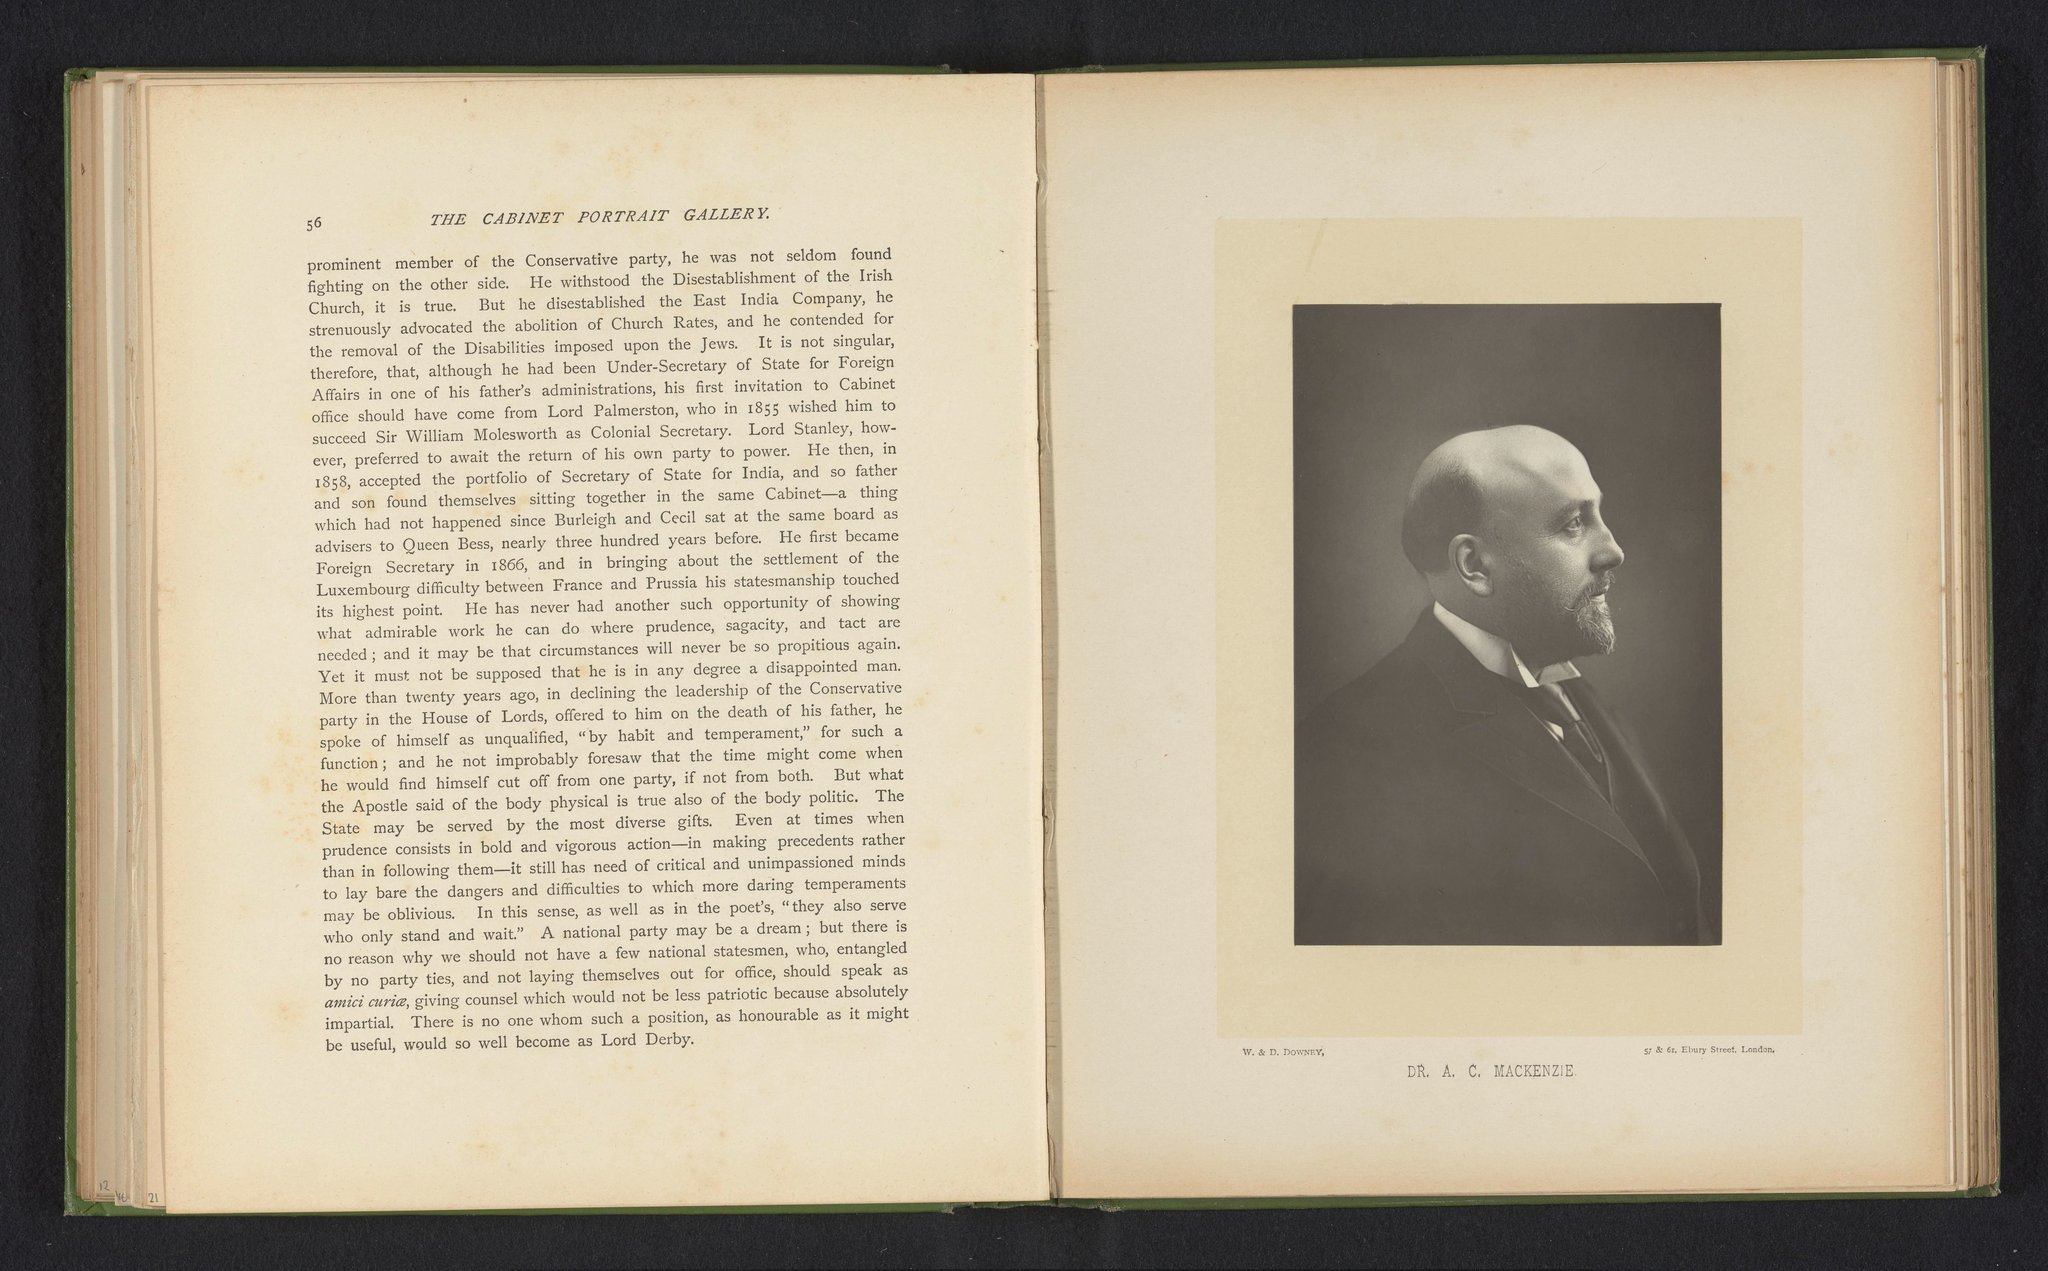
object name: photomechanical print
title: Portret van Alexander Mackenzie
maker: Anonymous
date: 1884-1894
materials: paper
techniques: woodburytype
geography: london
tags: composer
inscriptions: inscription: ‘57 & 61, Elbury Street, London.’